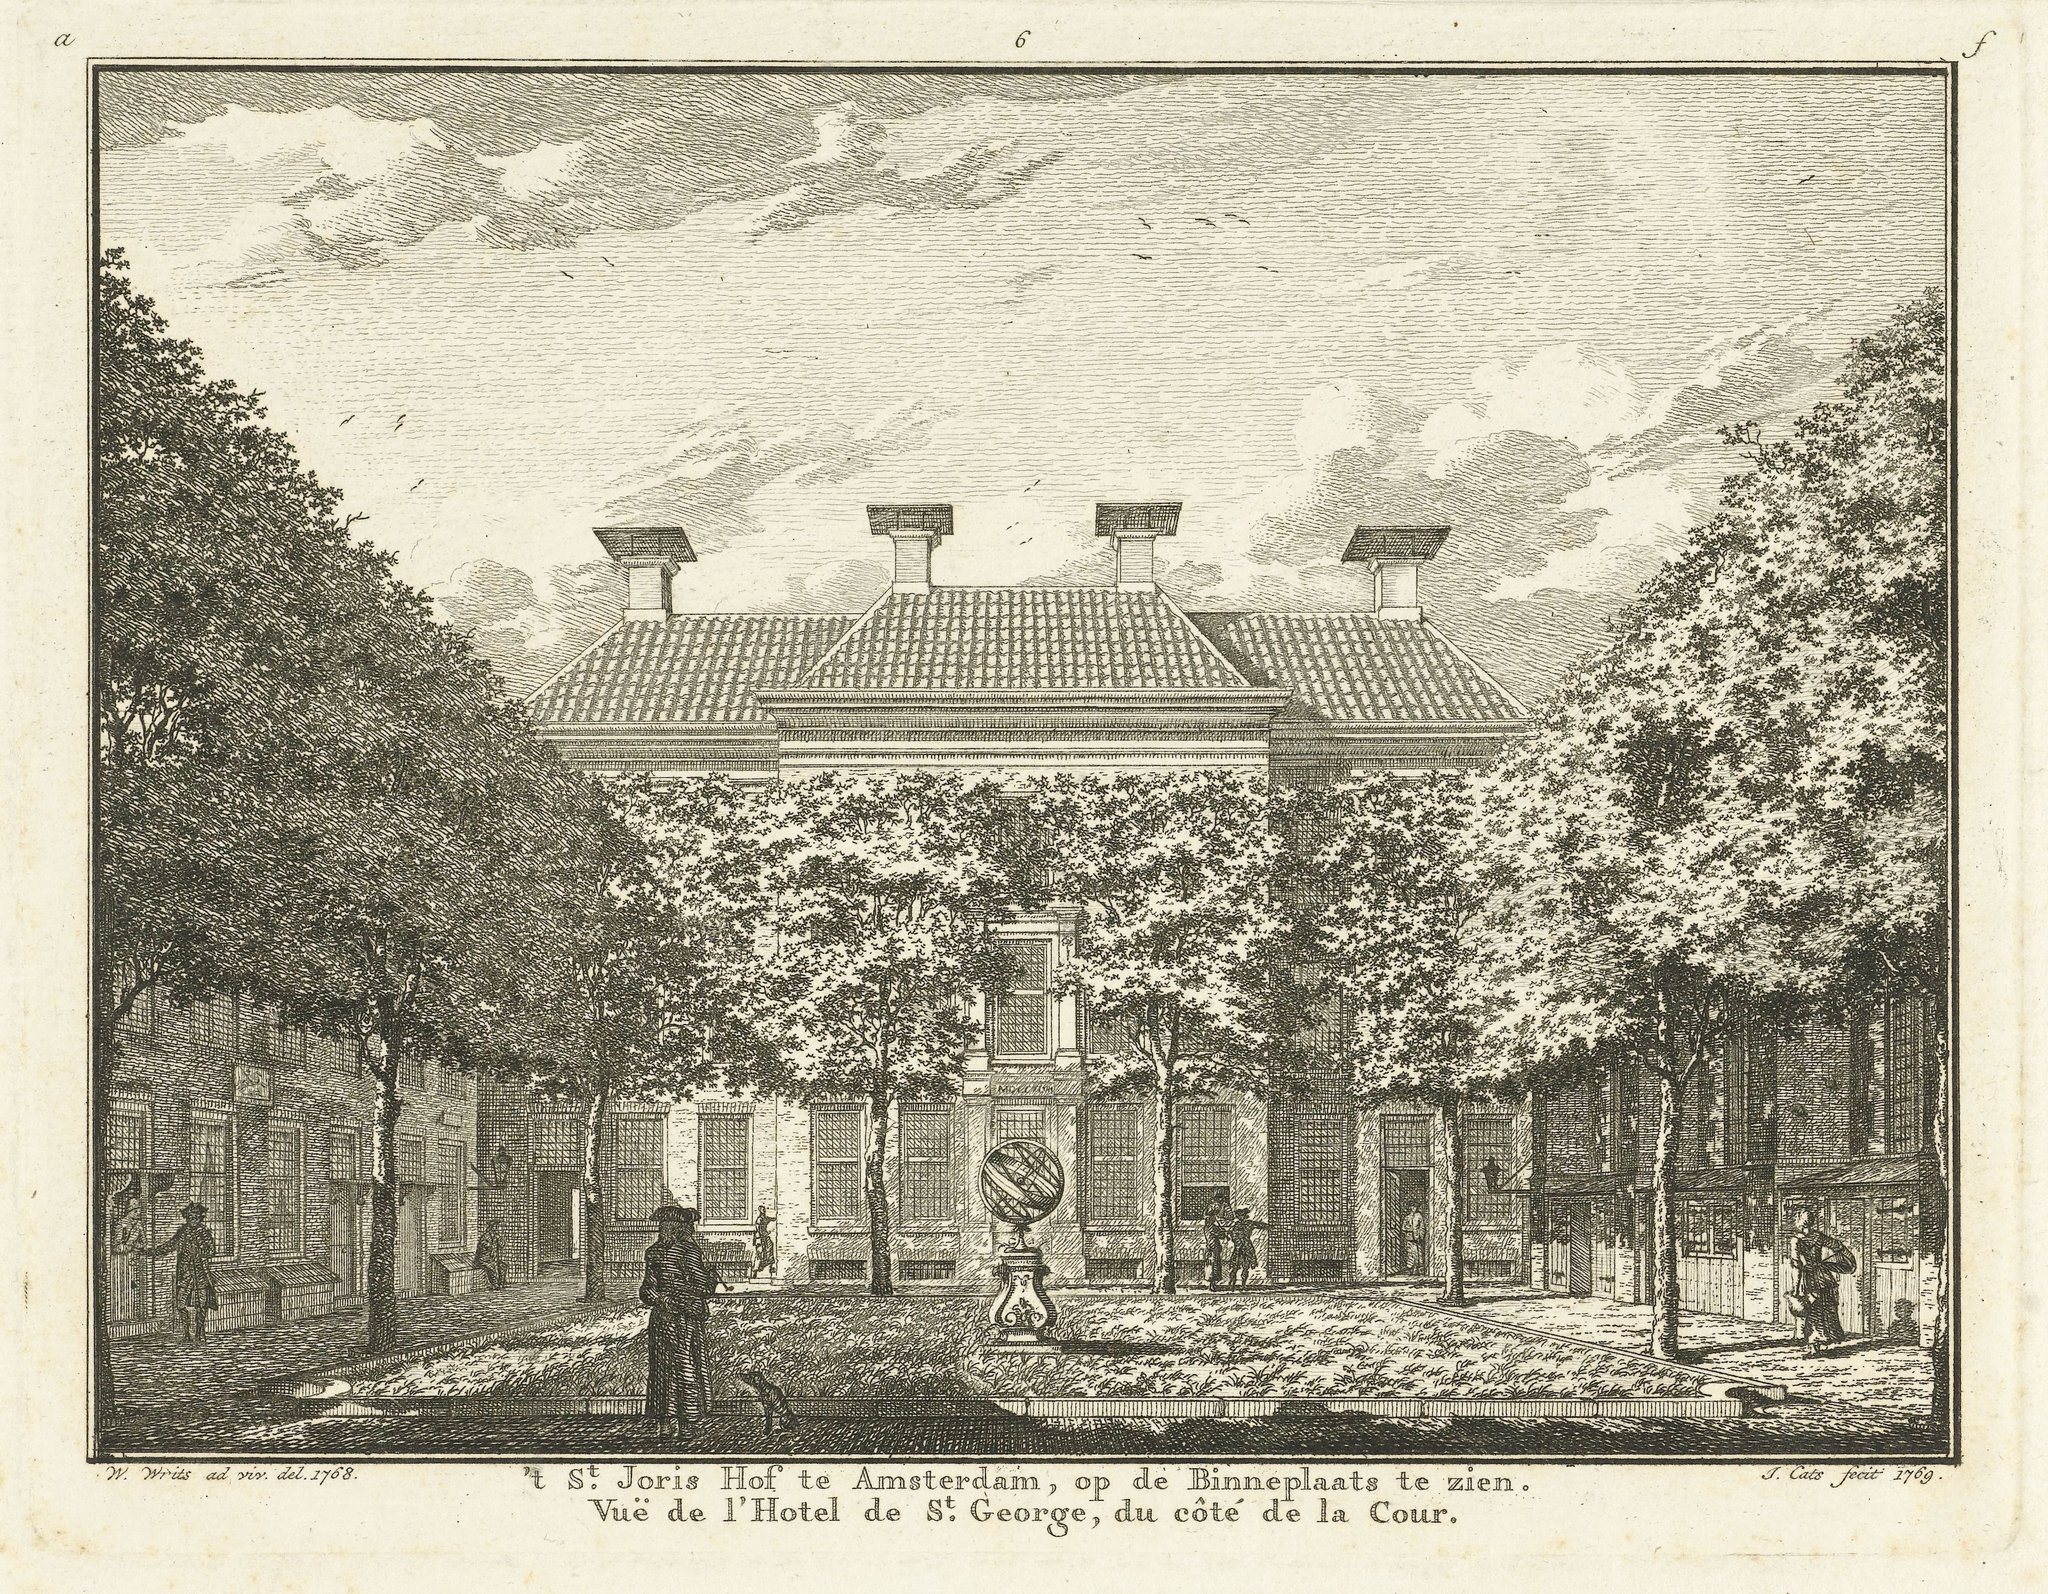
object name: print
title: Gezicht op de binnenplaats van het Sint-Jorishof te Amsterdam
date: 1769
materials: paper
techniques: etching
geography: amsterdam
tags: leprozenhuis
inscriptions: collector's mark: Lugt 2228